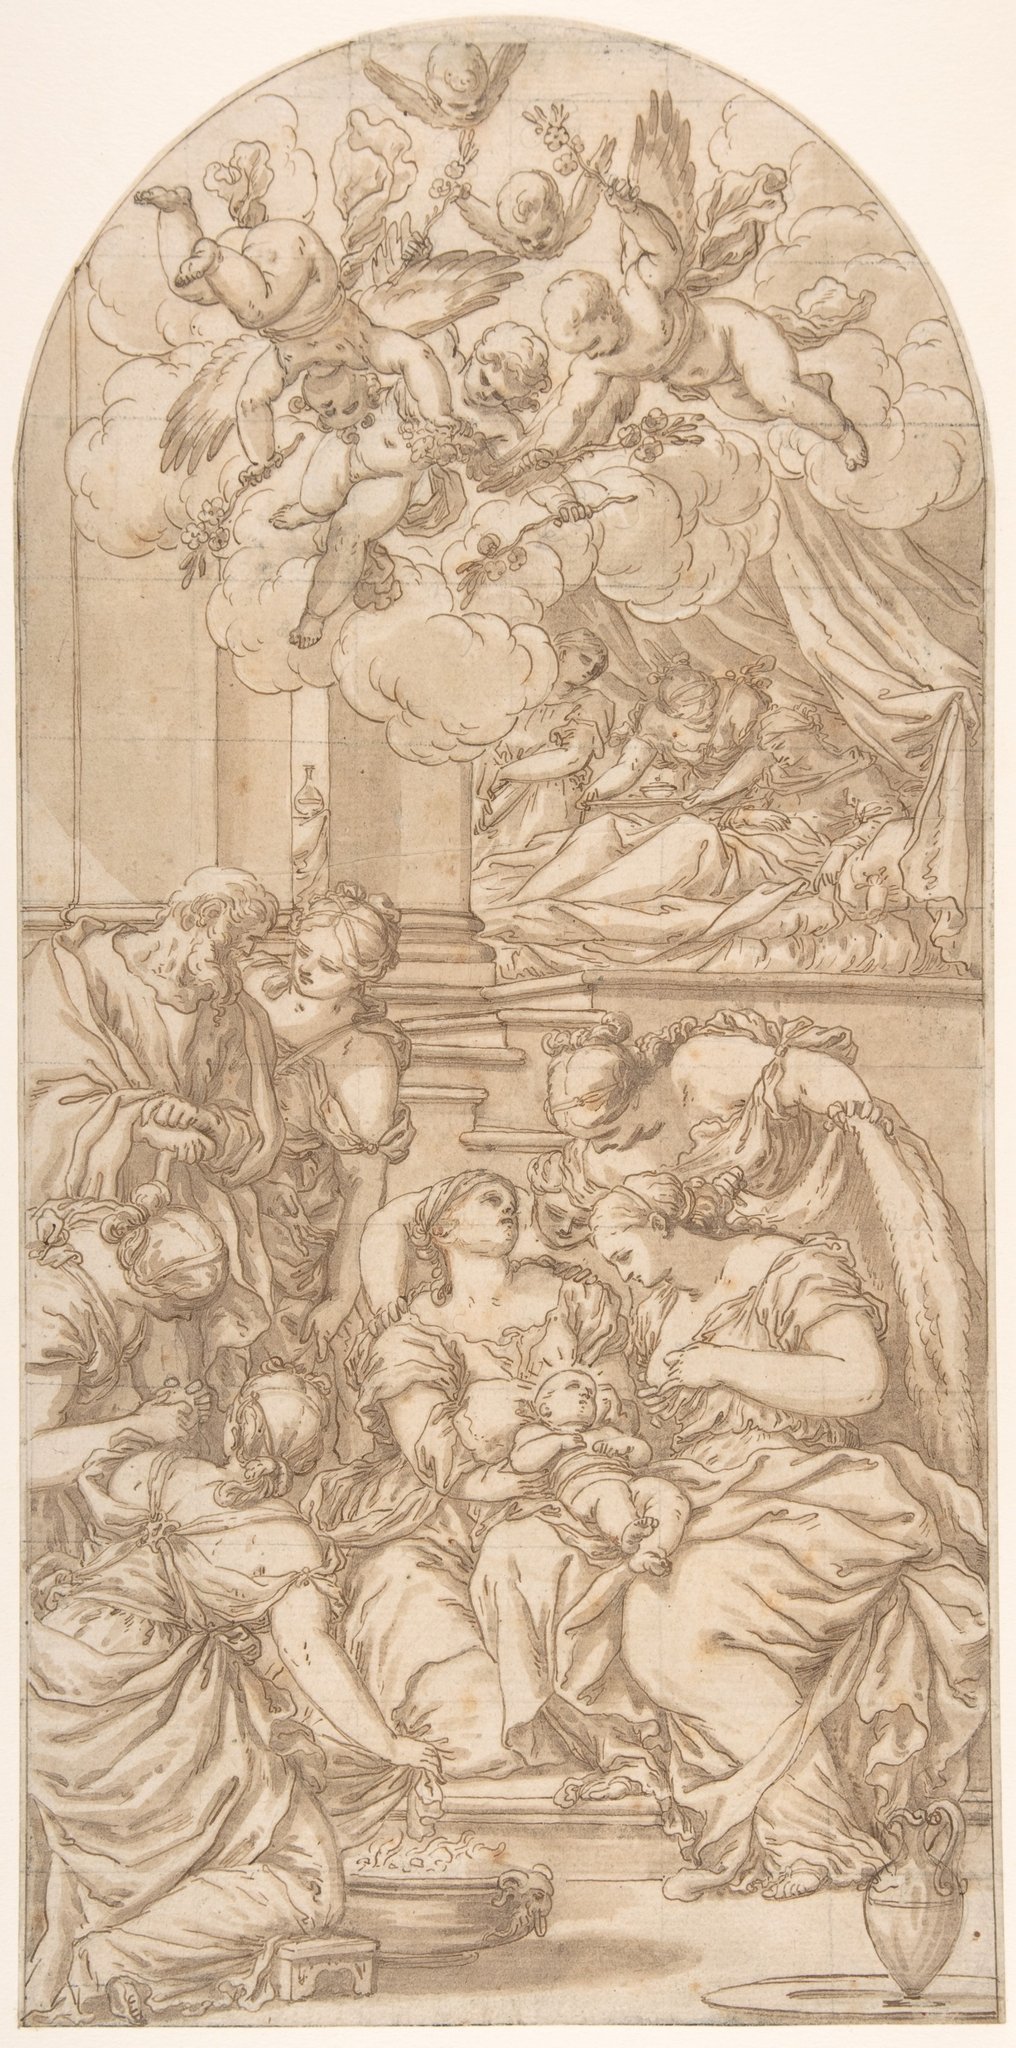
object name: drawing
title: Birth of St. John the Baptist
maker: valentin lefebvre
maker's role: artist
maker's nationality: flemish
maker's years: 1642-1682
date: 1601-1700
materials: chalk, ink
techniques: brush, pen, wash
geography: france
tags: men,women,angels,saint john the baptist,birth